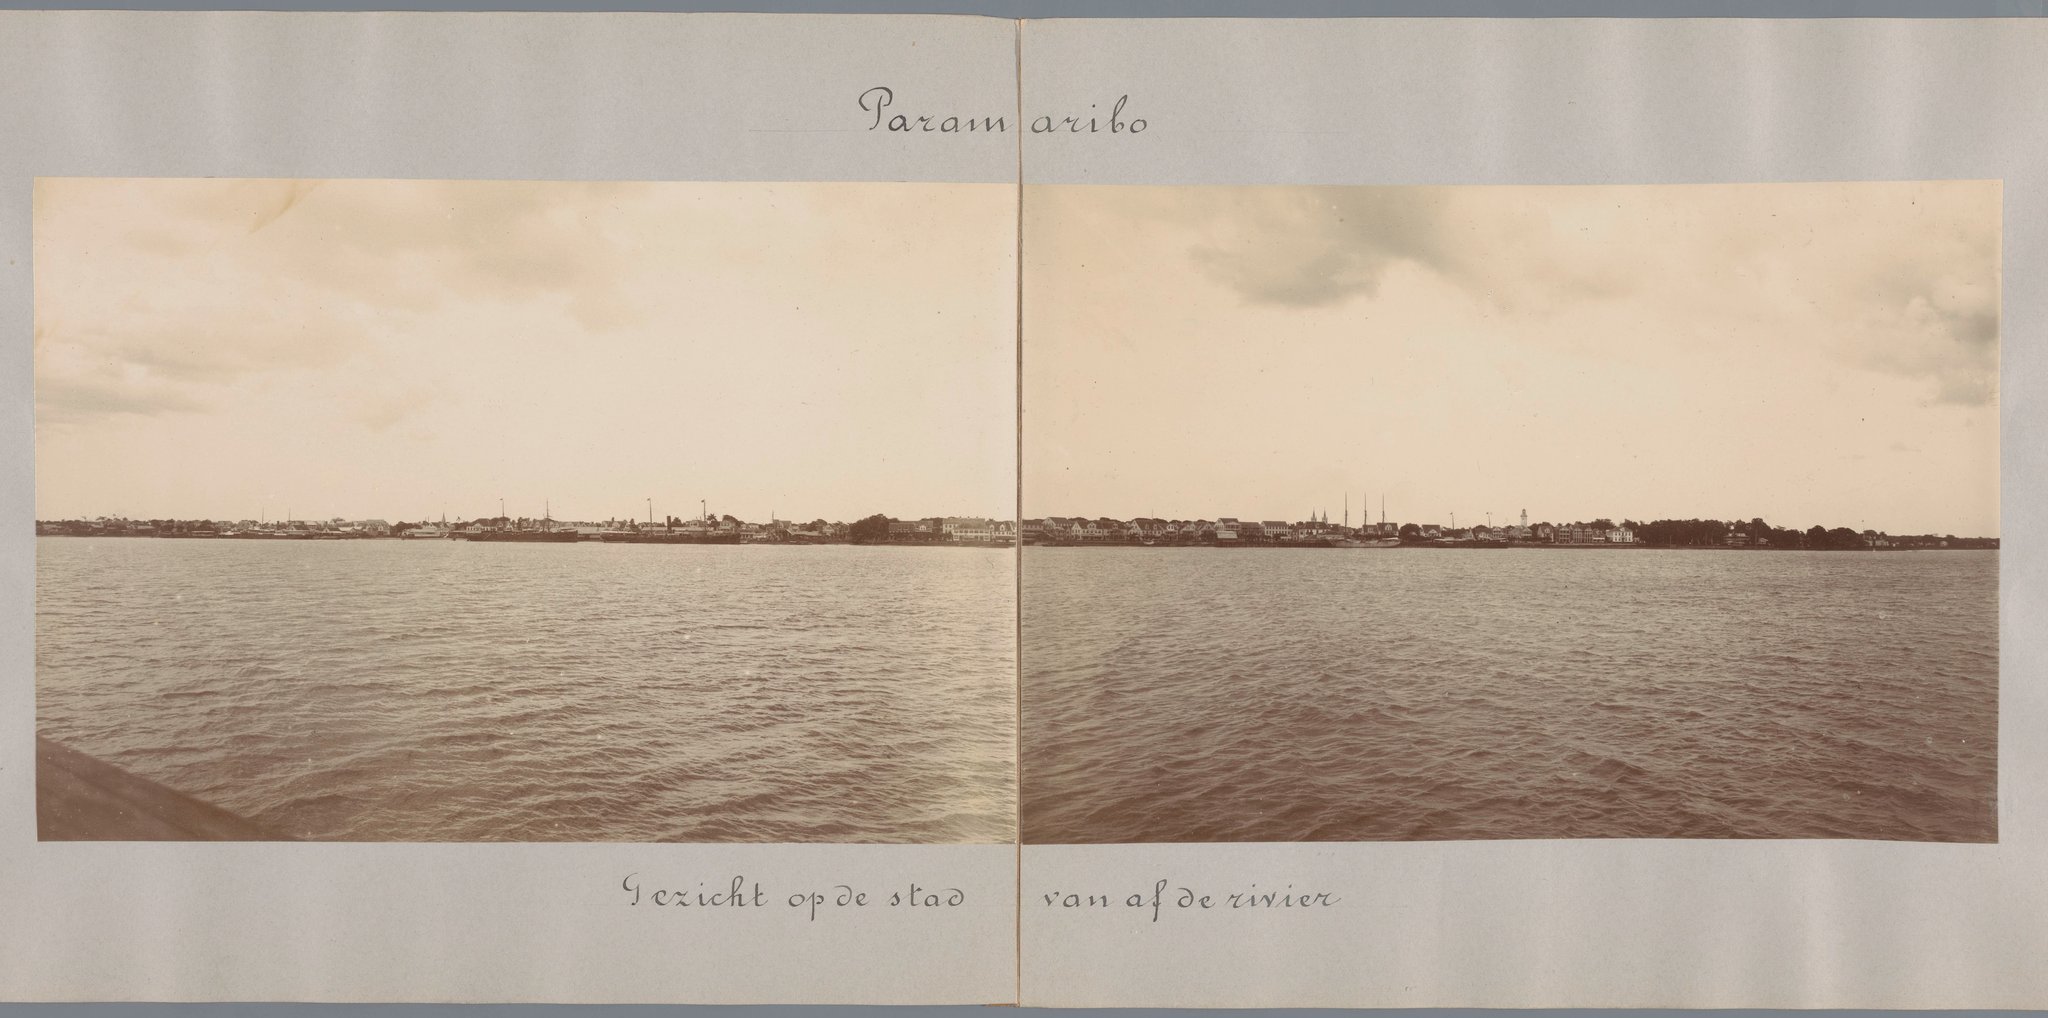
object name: photograph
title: Gezicht op de stad van af de rivier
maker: eugen klein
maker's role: fotograaf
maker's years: 1869-1927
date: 1900-1905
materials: cardboard, photographic support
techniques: gelatin silver print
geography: paramaribo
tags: paramaribo (stad)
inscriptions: inscription: ‘Paramaribo / Gezicht op de stad van af de rivier’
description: Weids gezicht op de stad Paramaribo, gezien vanaf het water. Panorama samengesteld uit twee aan elkaar geplakte fotoafdrukken. Onderdeel van een groep van 44 foto's van Paramaribo, Suriname en Curaçao, ca. 1900-1905, opgeplakt op kartons en voorzien van opschriften.